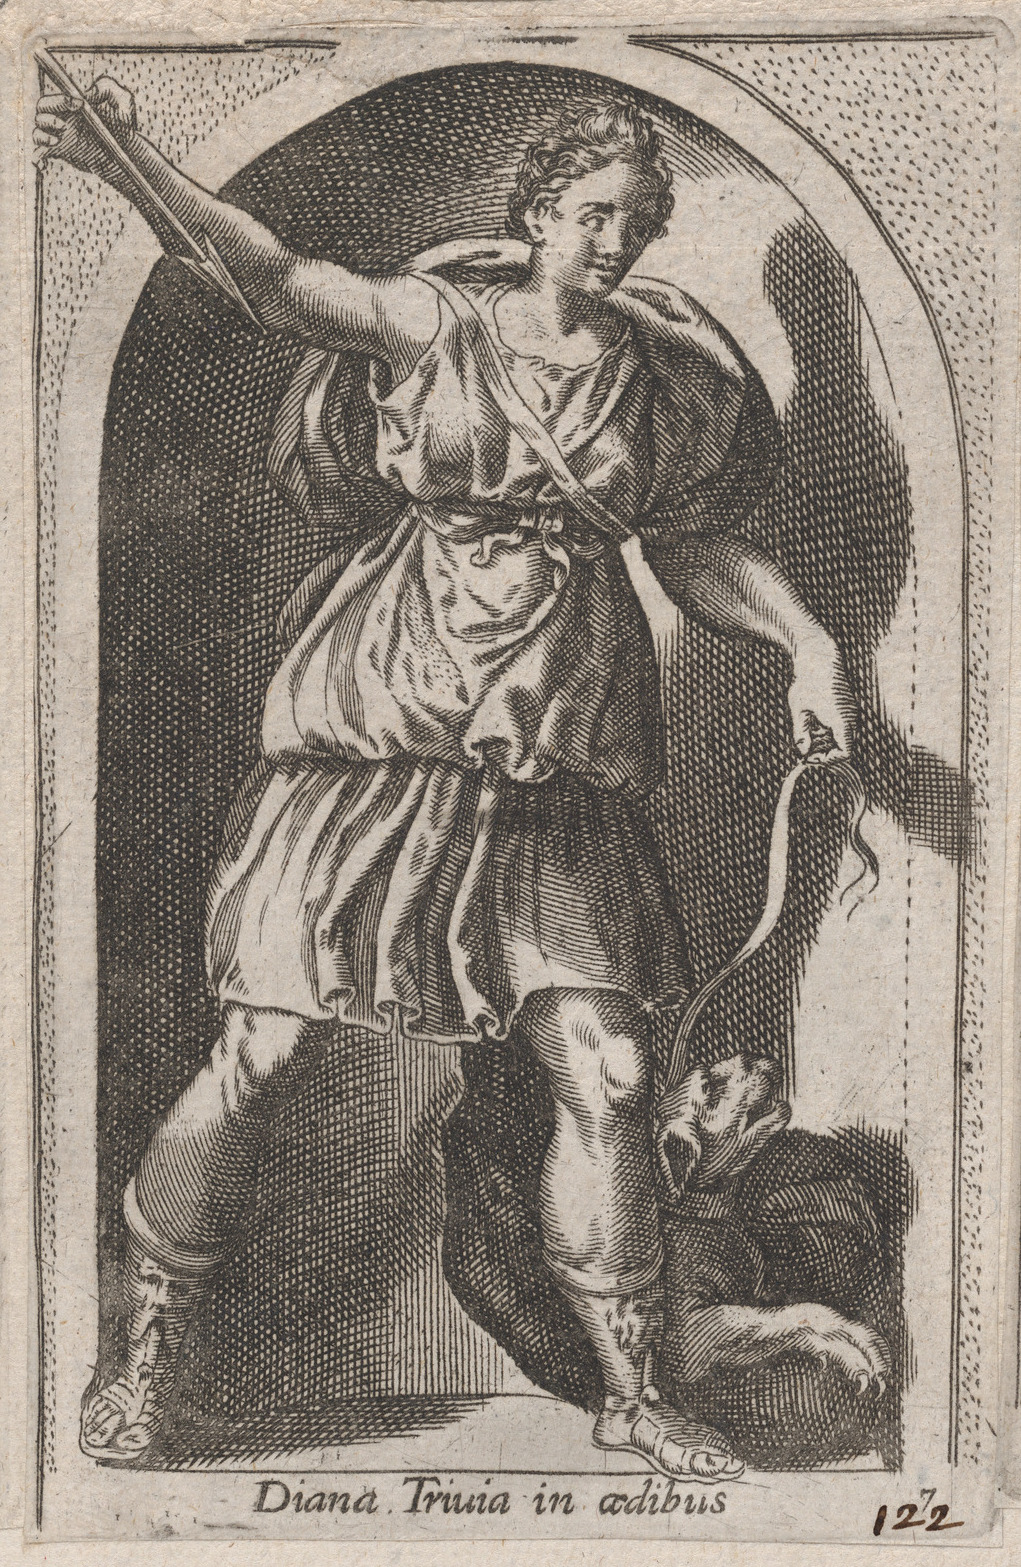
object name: print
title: Diana (Diana Triuia in aedibus), from "Speculum Romanae Magnificentiae"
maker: Anonymous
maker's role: artist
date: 1501-1600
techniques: engraving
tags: arrows,diana,dogs